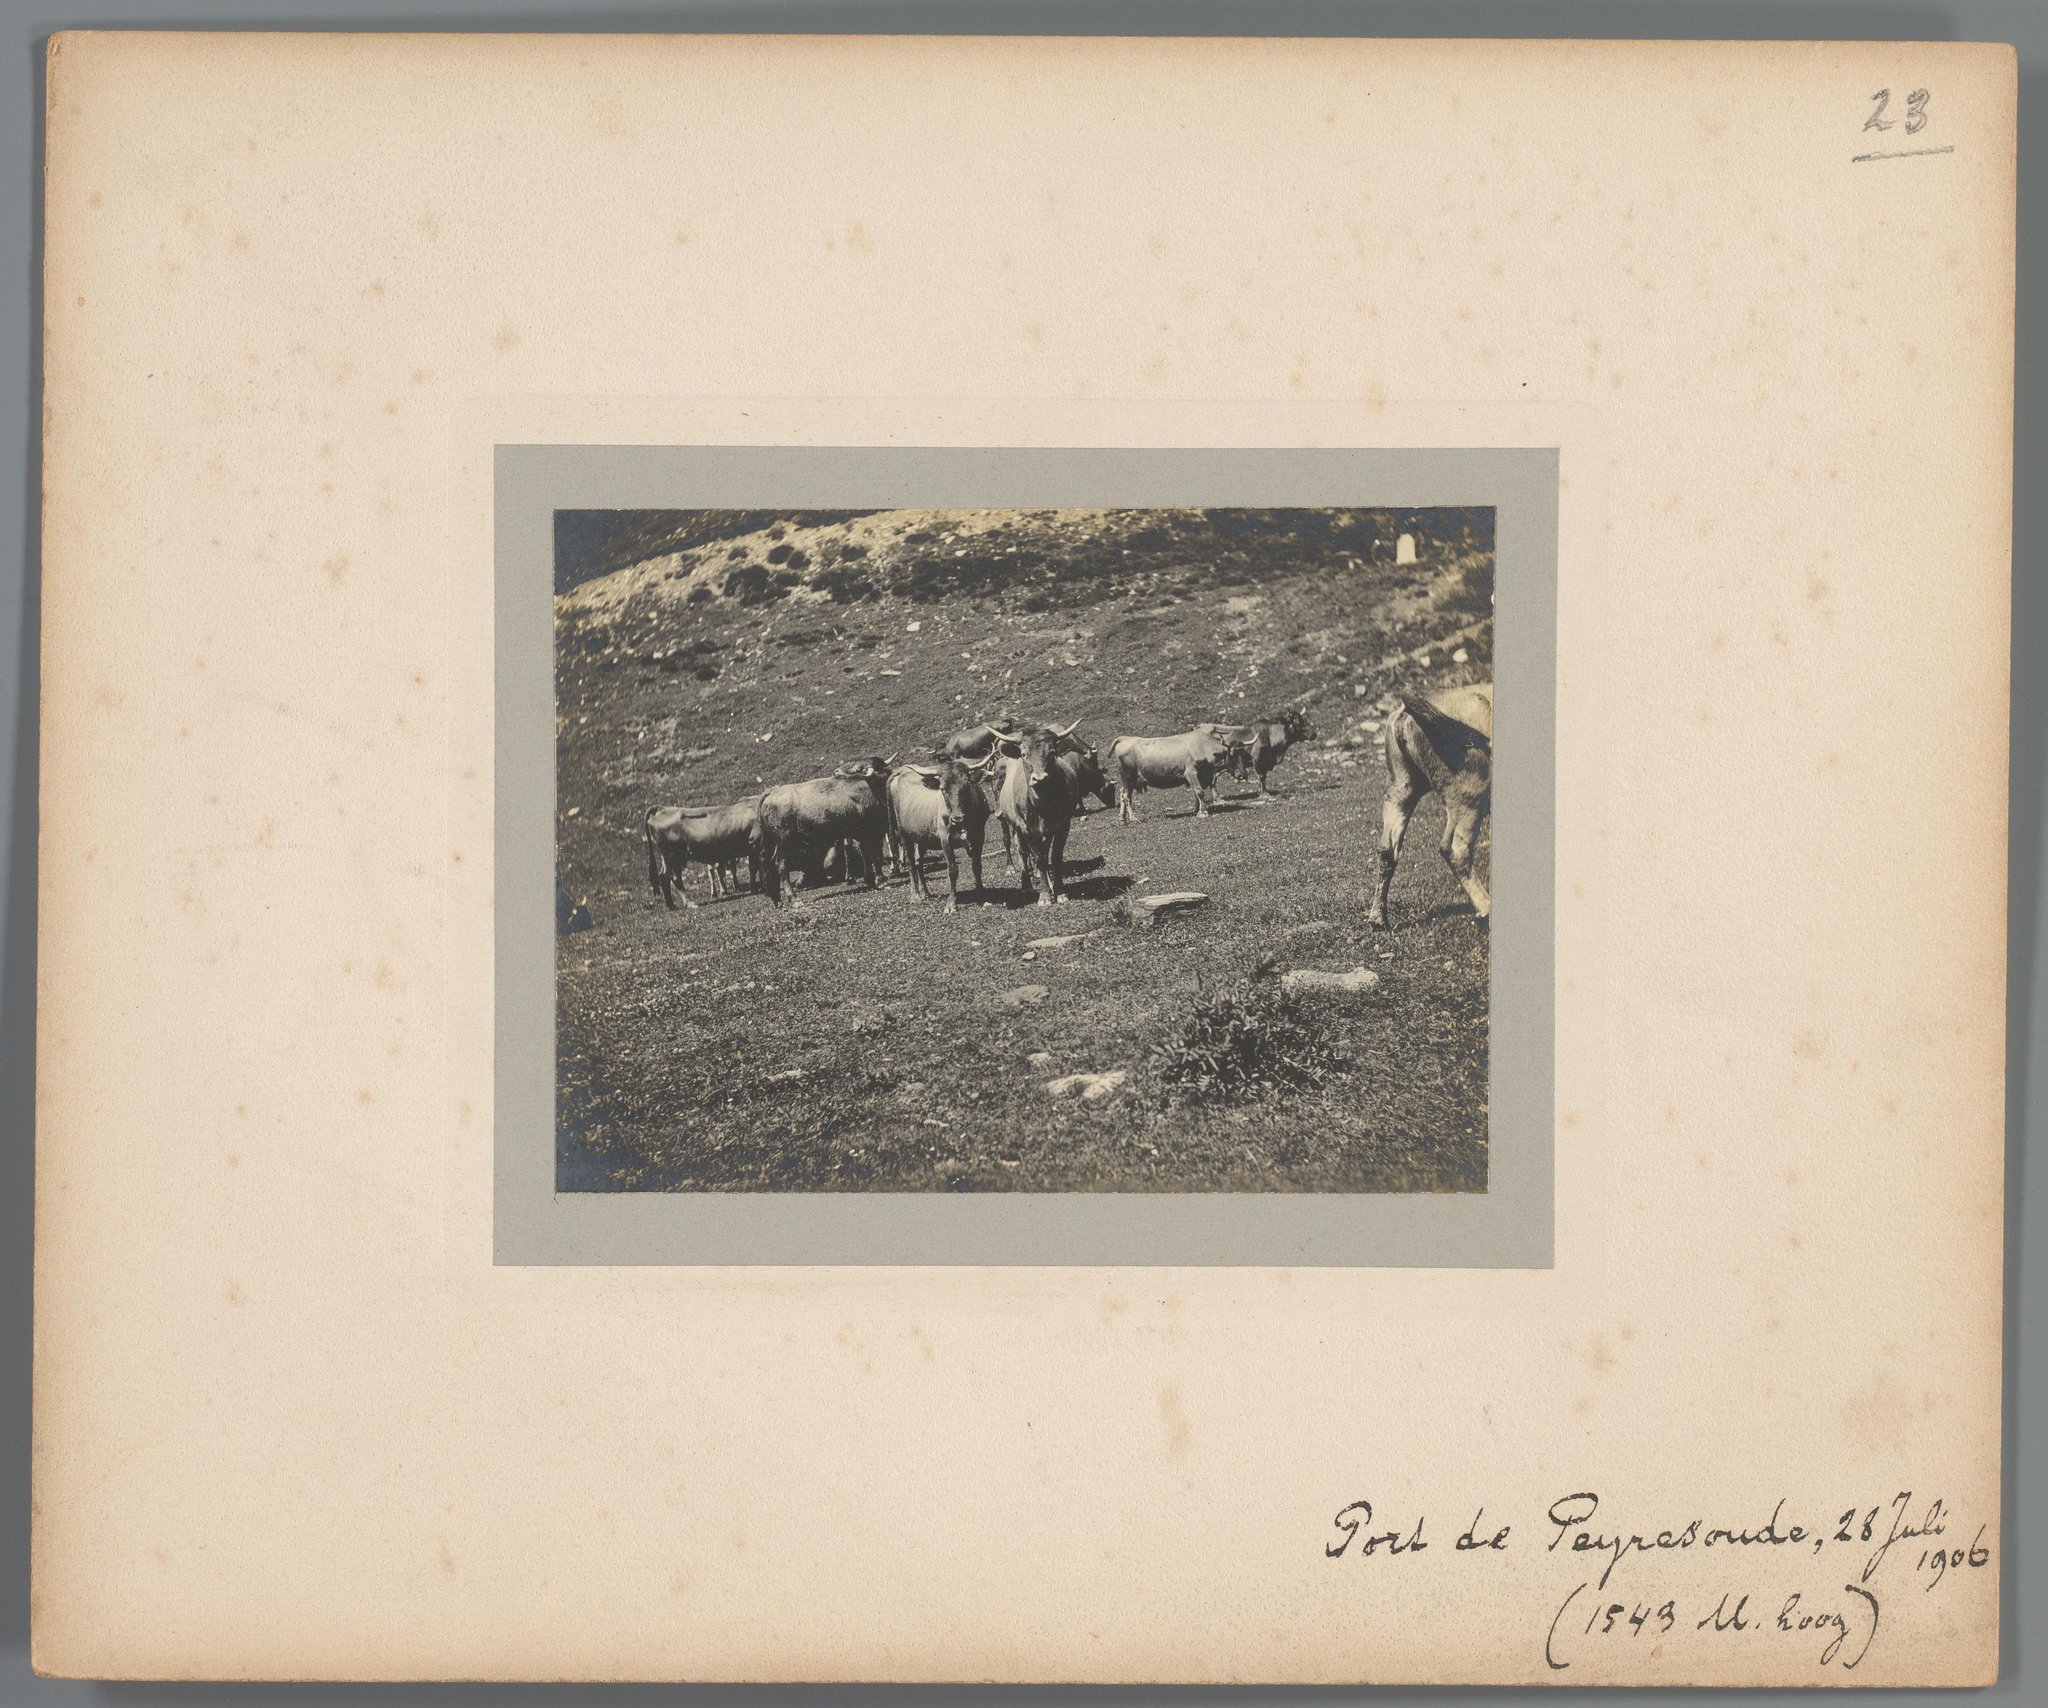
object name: photograph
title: Port de Peyresoude (1543 M. hoog)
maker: françois buys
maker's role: advocaat, amateurfotograaf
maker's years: 1871-1934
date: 1906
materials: paper, cardboard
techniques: gelatin silver print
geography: col de peyresourde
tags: cow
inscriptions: number: ‘23’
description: Deze foto maakt deel uit van een groep van 49 foto's.